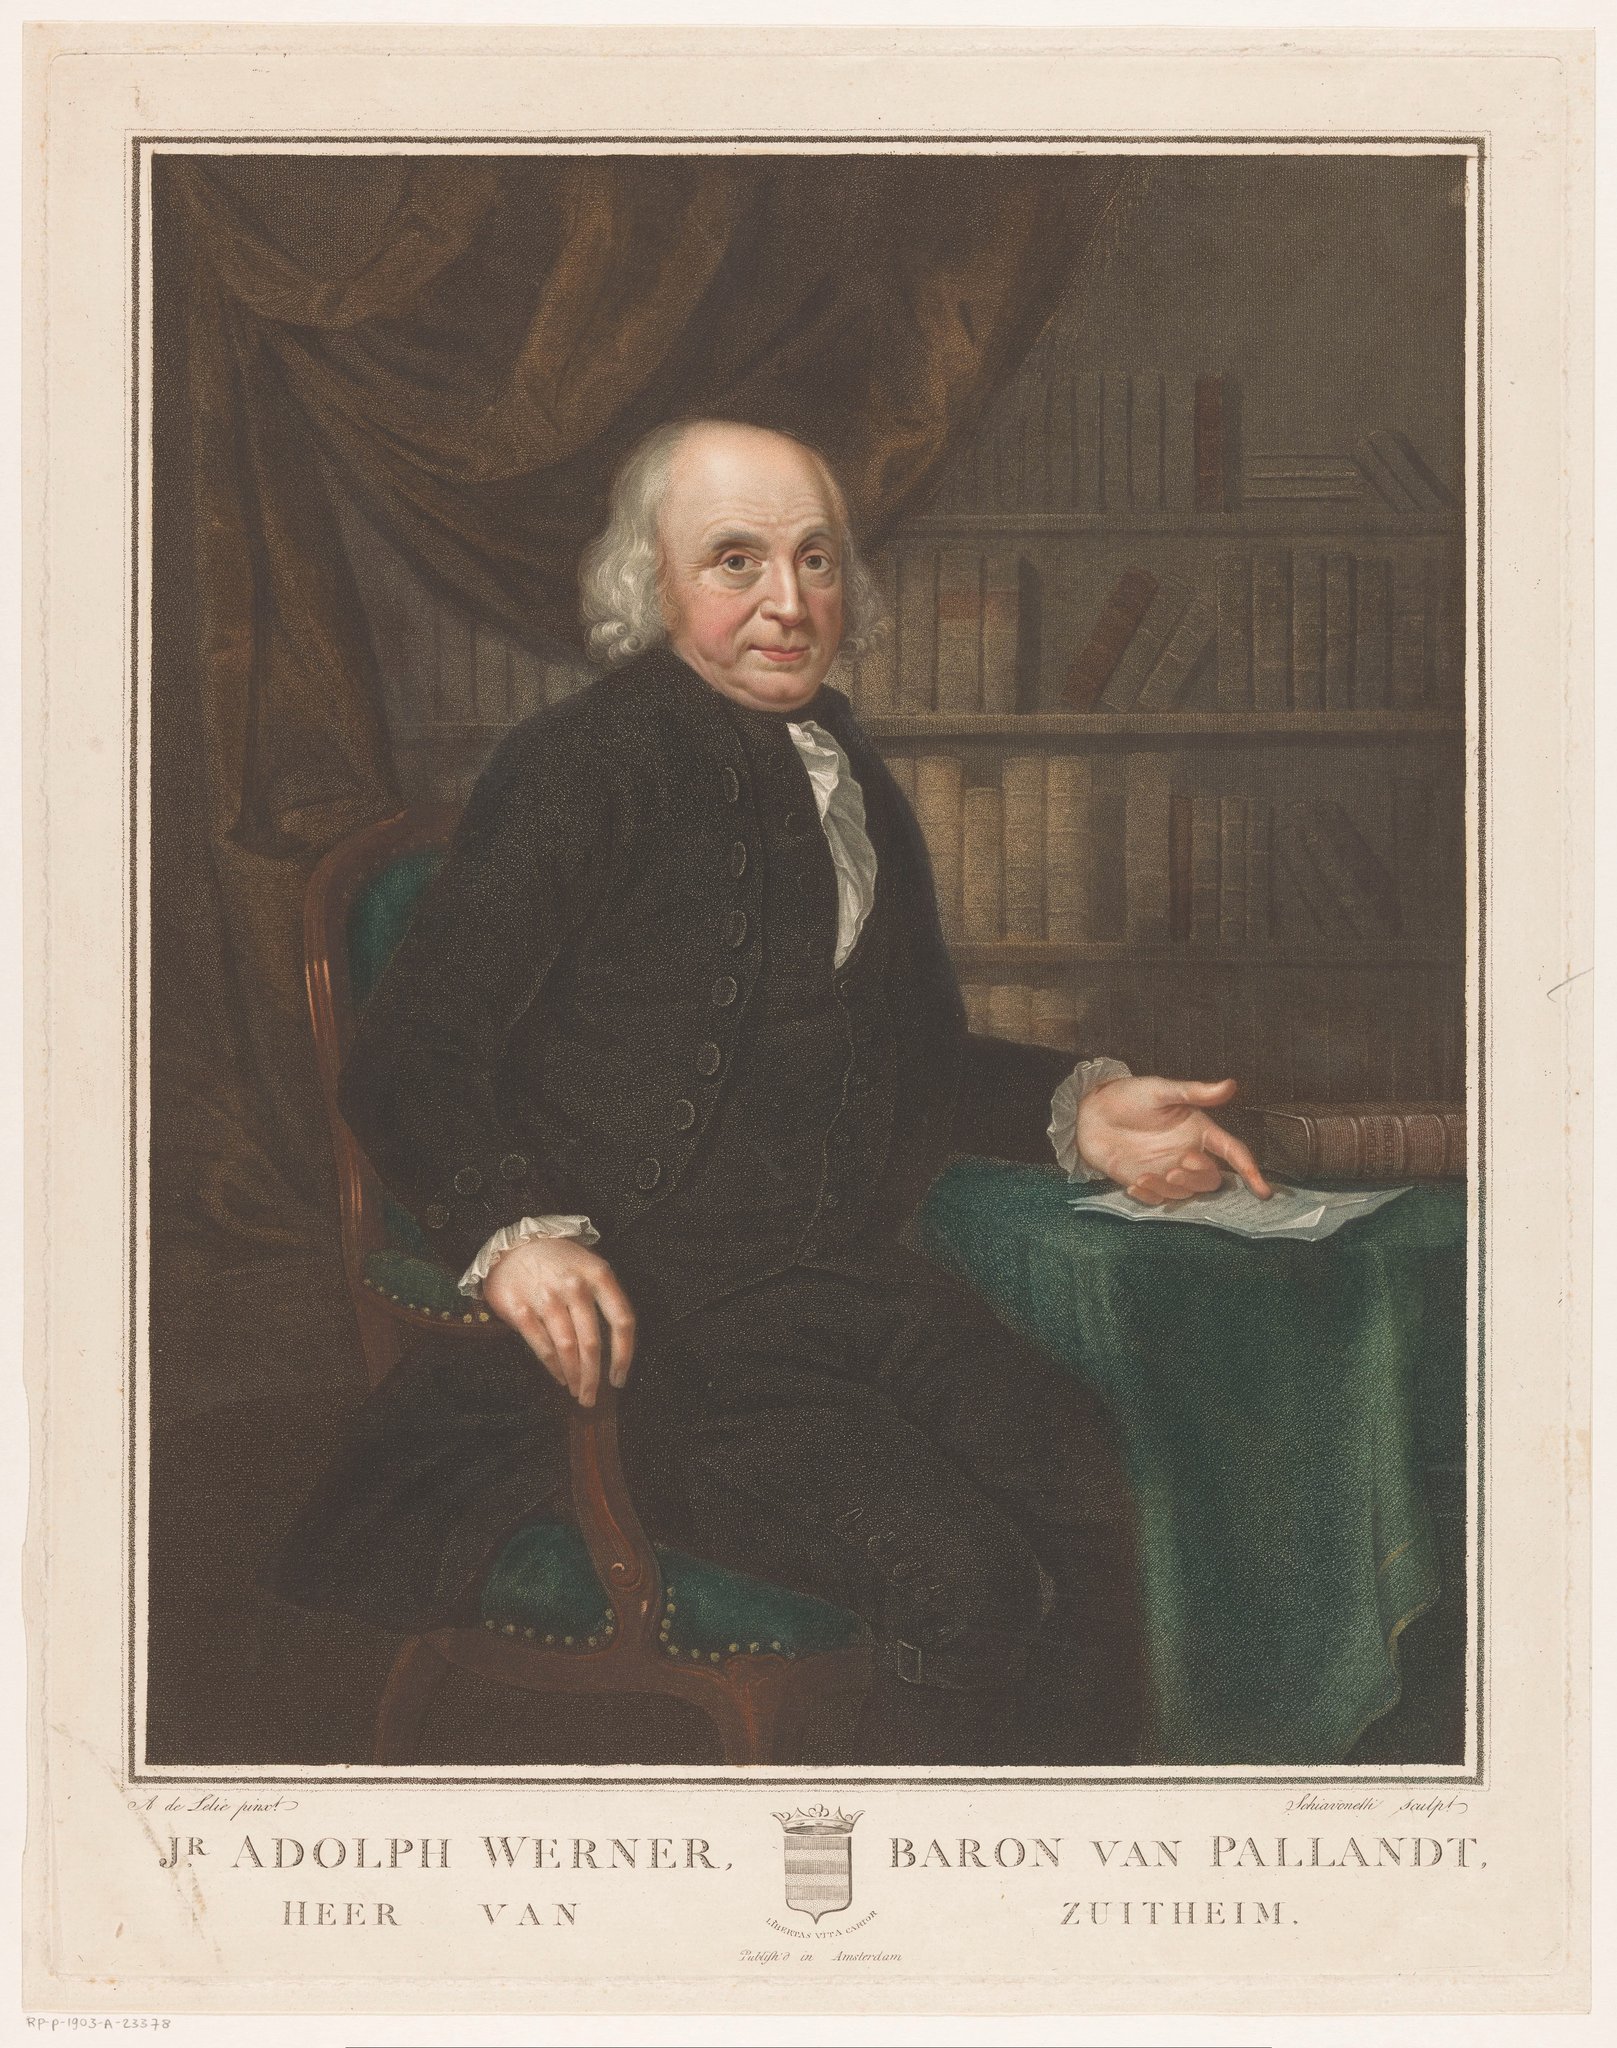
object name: print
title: Portret van Adolph Werner van Pallandt tot Zuthem, drost van IJsselmuiden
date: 1790-1810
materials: paper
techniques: engraving, etching, hand coloring, lithography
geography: amsterdam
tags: historical persons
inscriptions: collector's mark: Lugt 2228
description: Prent naar een schilderij door Adriaan de Lelie in het Stedelijk Museum Zwolle (inv.nr. 408).